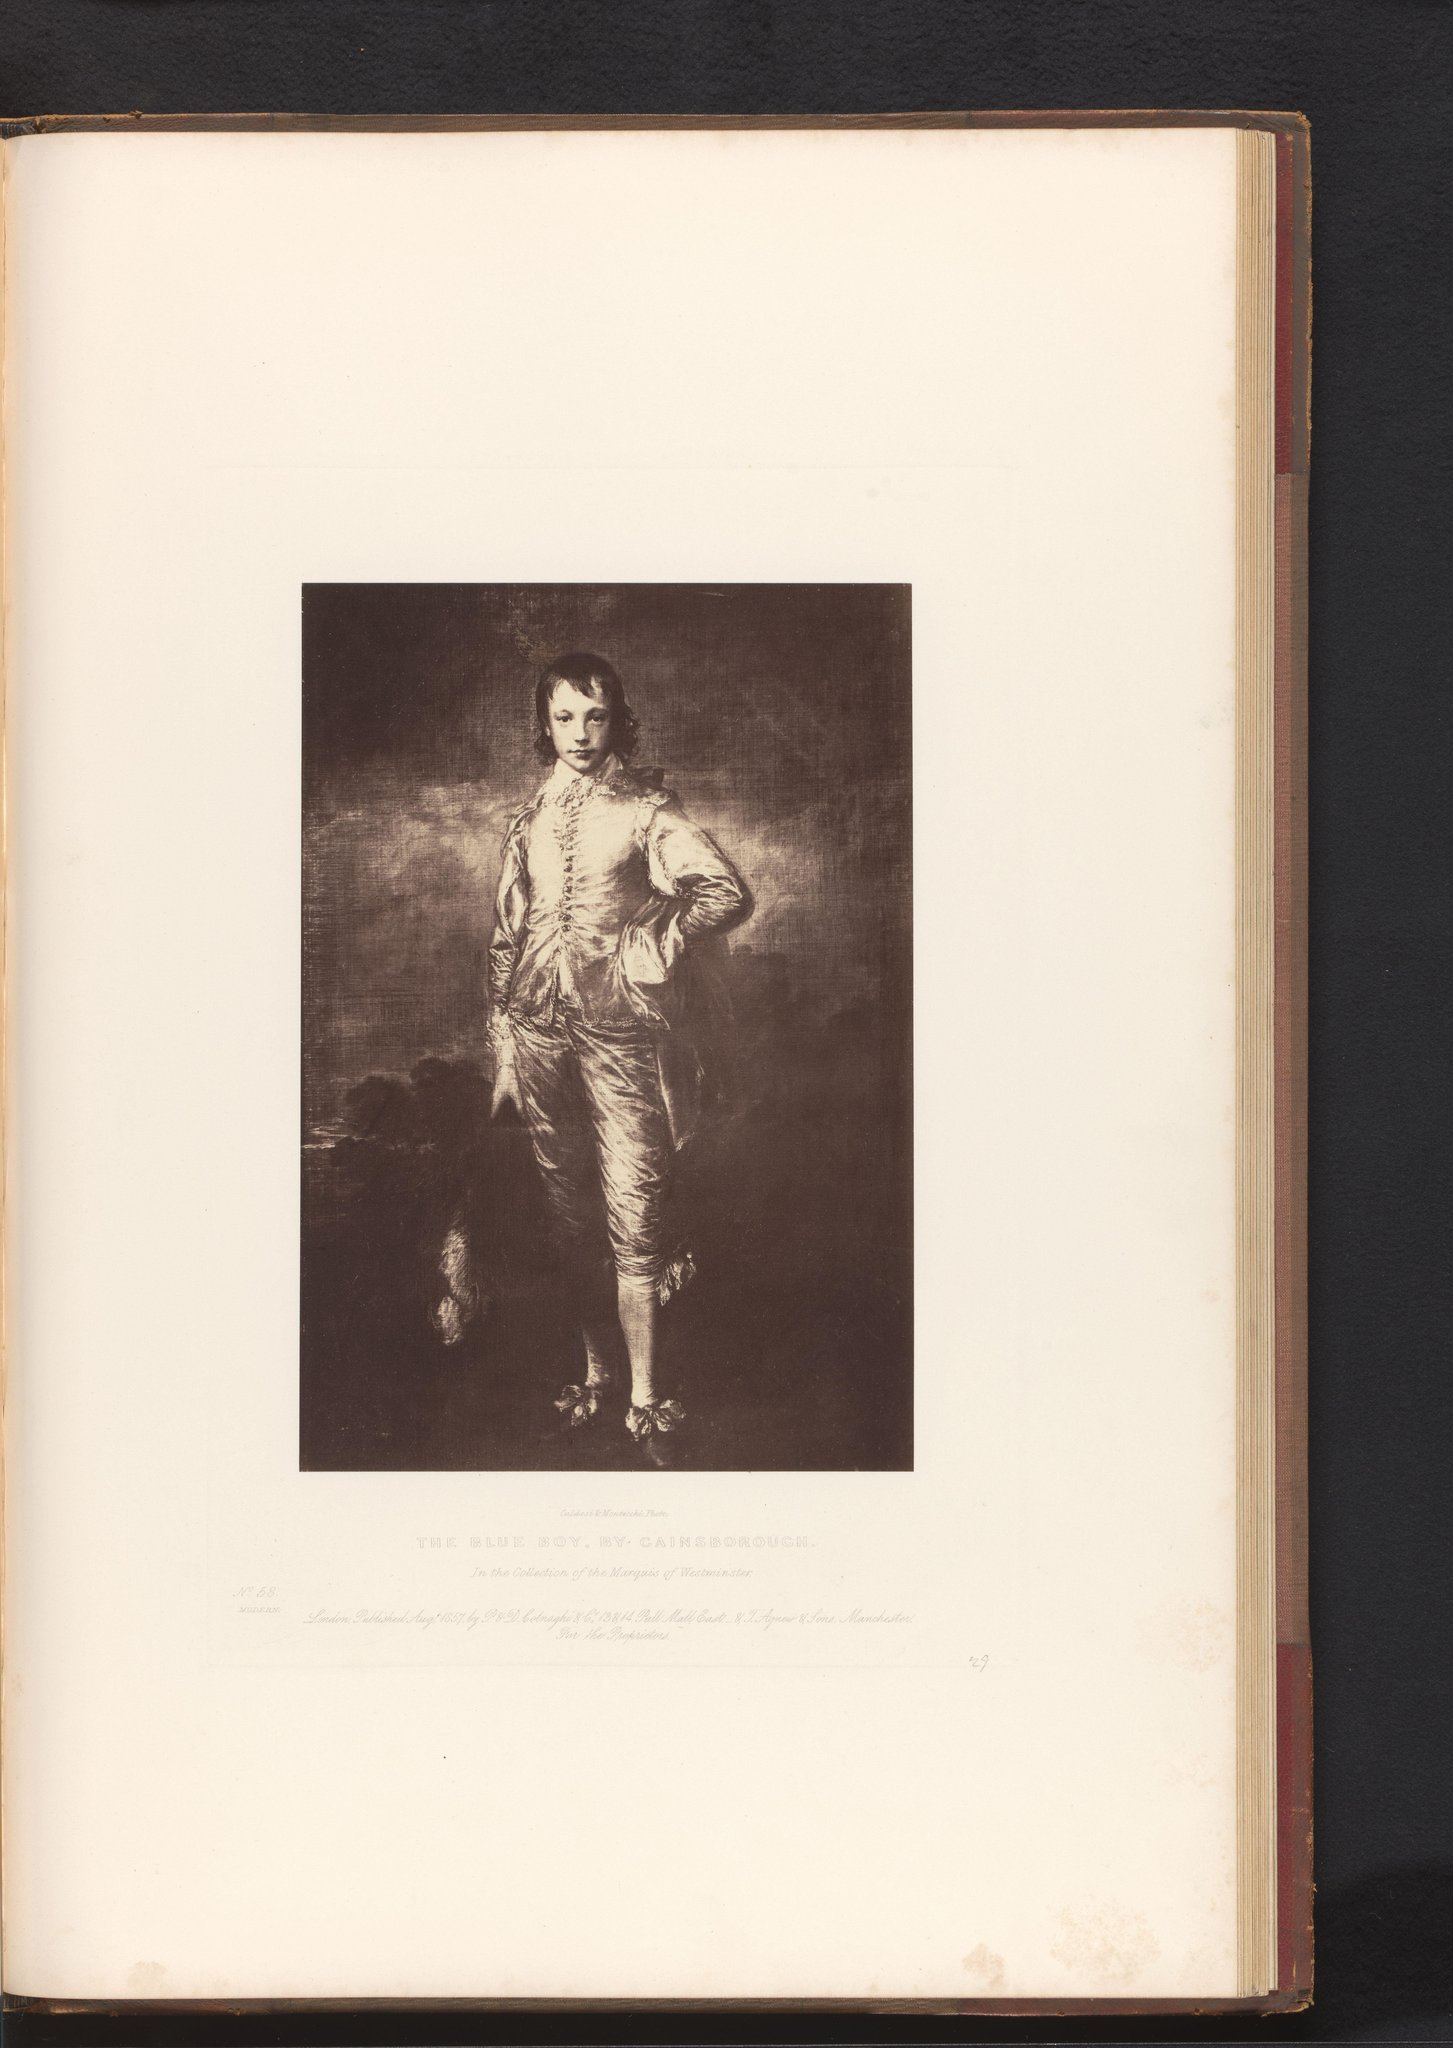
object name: page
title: Fotoreproductie van The Blue Boy door Thomas Gainsborough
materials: photographic support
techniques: albumen print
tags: boy (child between toddler and youth), historical persons not known by name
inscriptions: inscription: ‘In the Collection of the Marquis of Westminster./ London, Published Augt, 1857, by P. & D. Colnaghi & Co, 13 & 14, Pall Mall East & T. Agneur & Sons, Manchester./ For the Proprietors.’, number: ‘No. 58./ MODERN.’, number: ‘29’